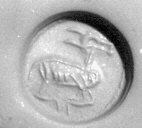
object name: stamp seal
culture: sasanian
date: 201-700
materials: bronze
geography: iran or mesopotamia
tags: animals